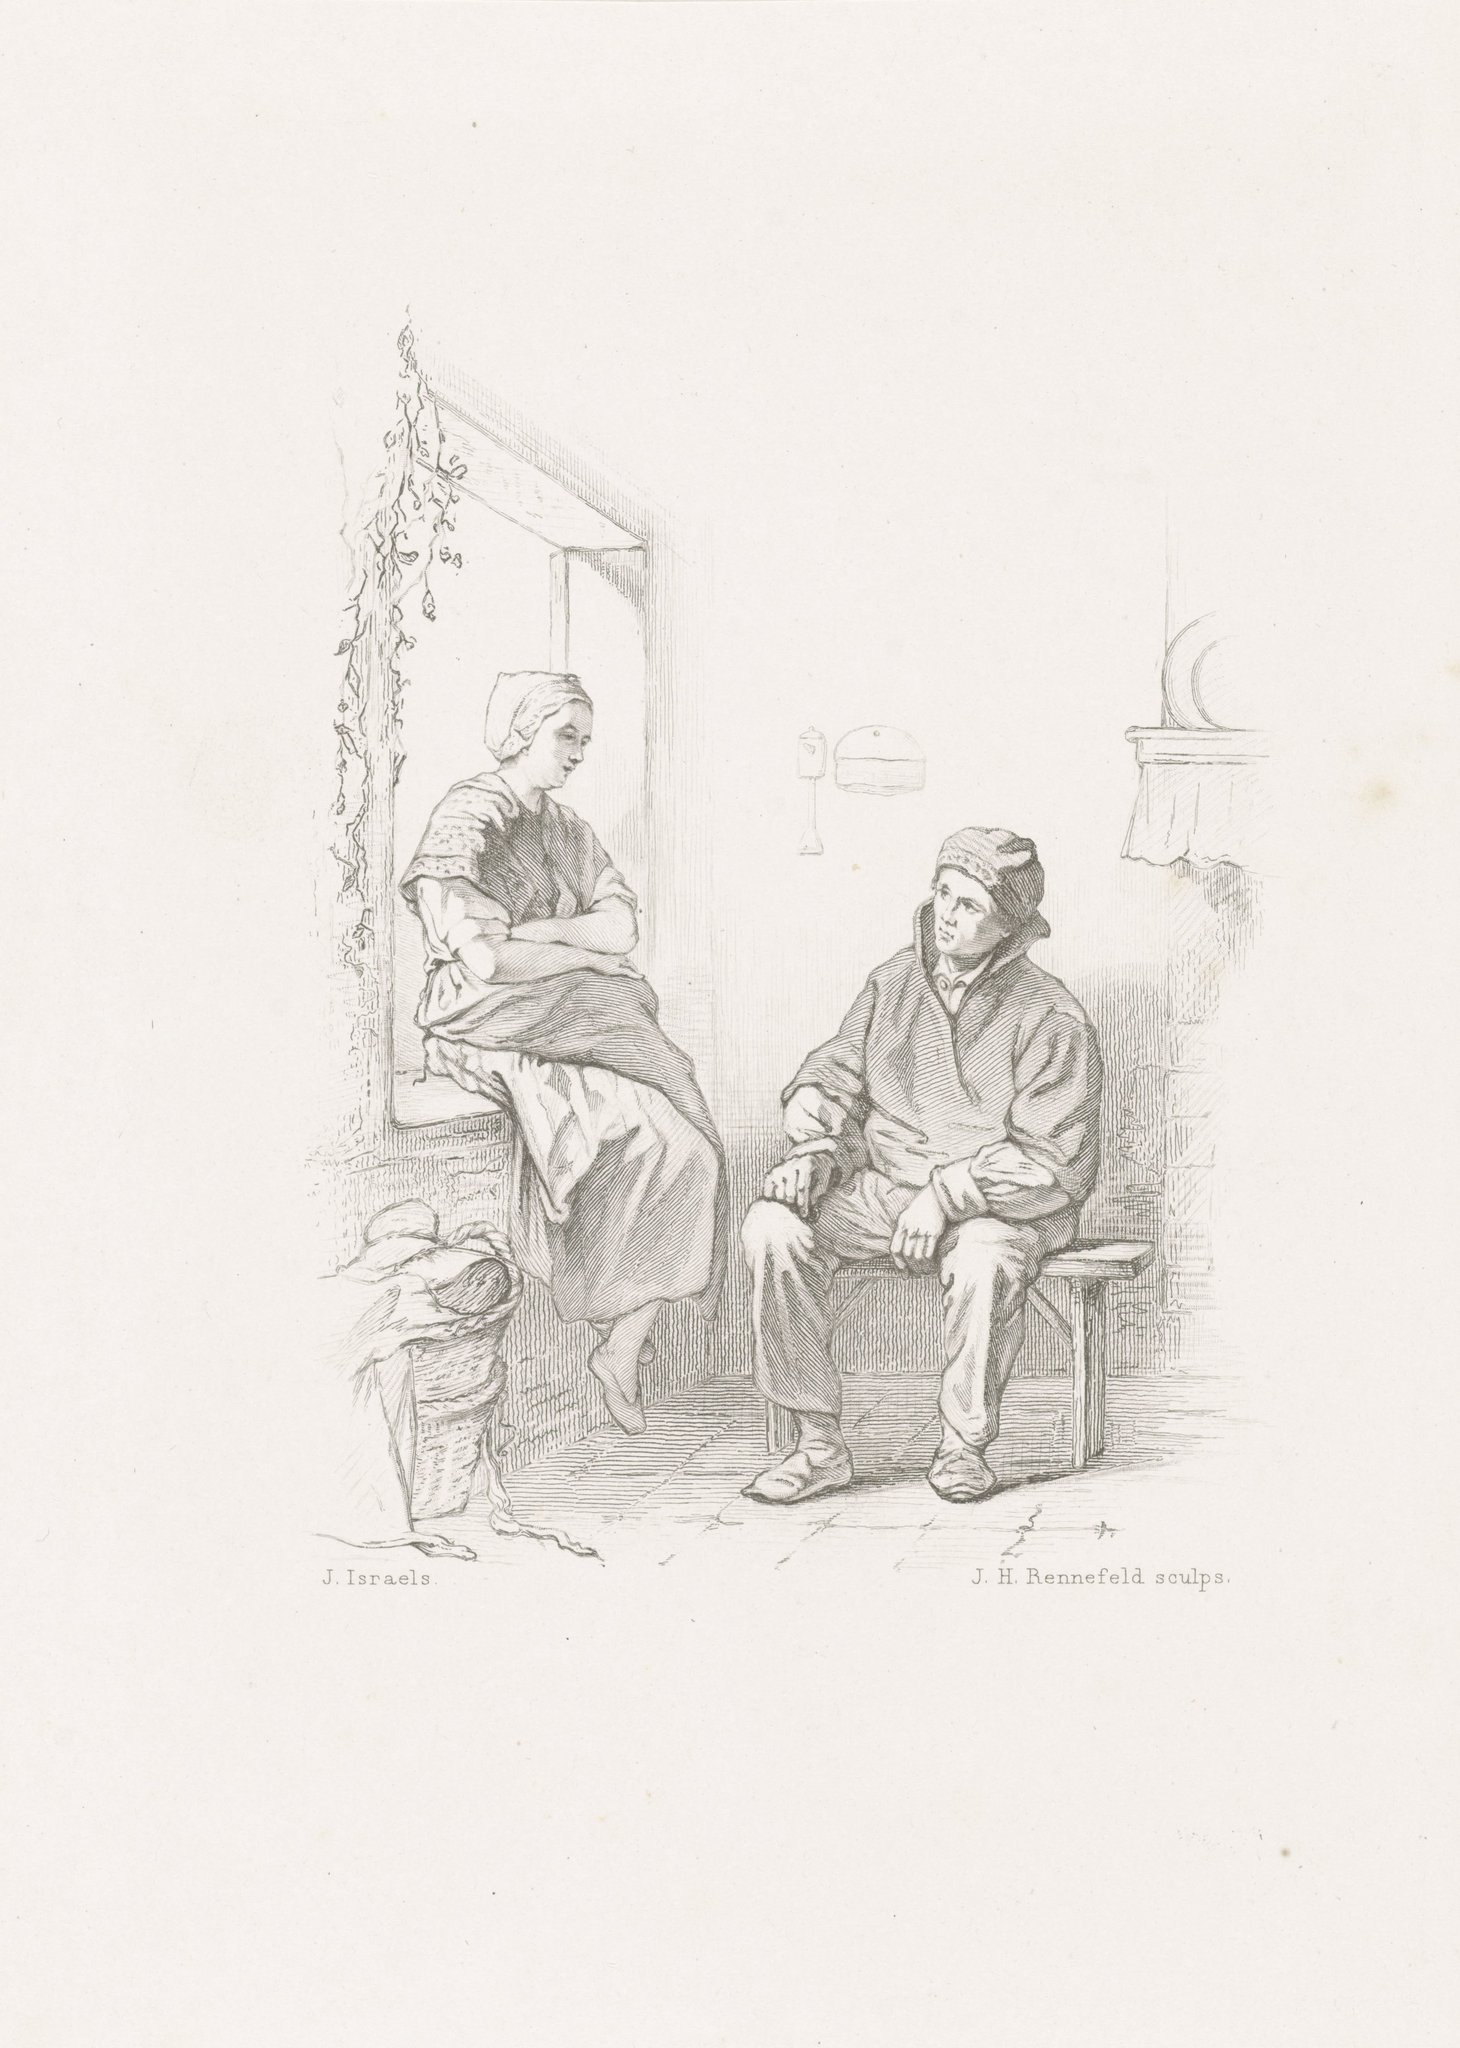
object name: print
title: De kinderen der zee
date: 1861-1872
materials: paper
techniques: roulette, engraving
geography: amsterdam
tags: fisherman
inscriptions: collector's mark: Lugt 2228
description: Een jonge visser doet een vissersmeisje een huwelijksaanzoek. In de hand houdt de man een ring. De prent maakt deel uit van de serie prenten 'De kinderen der zee'.